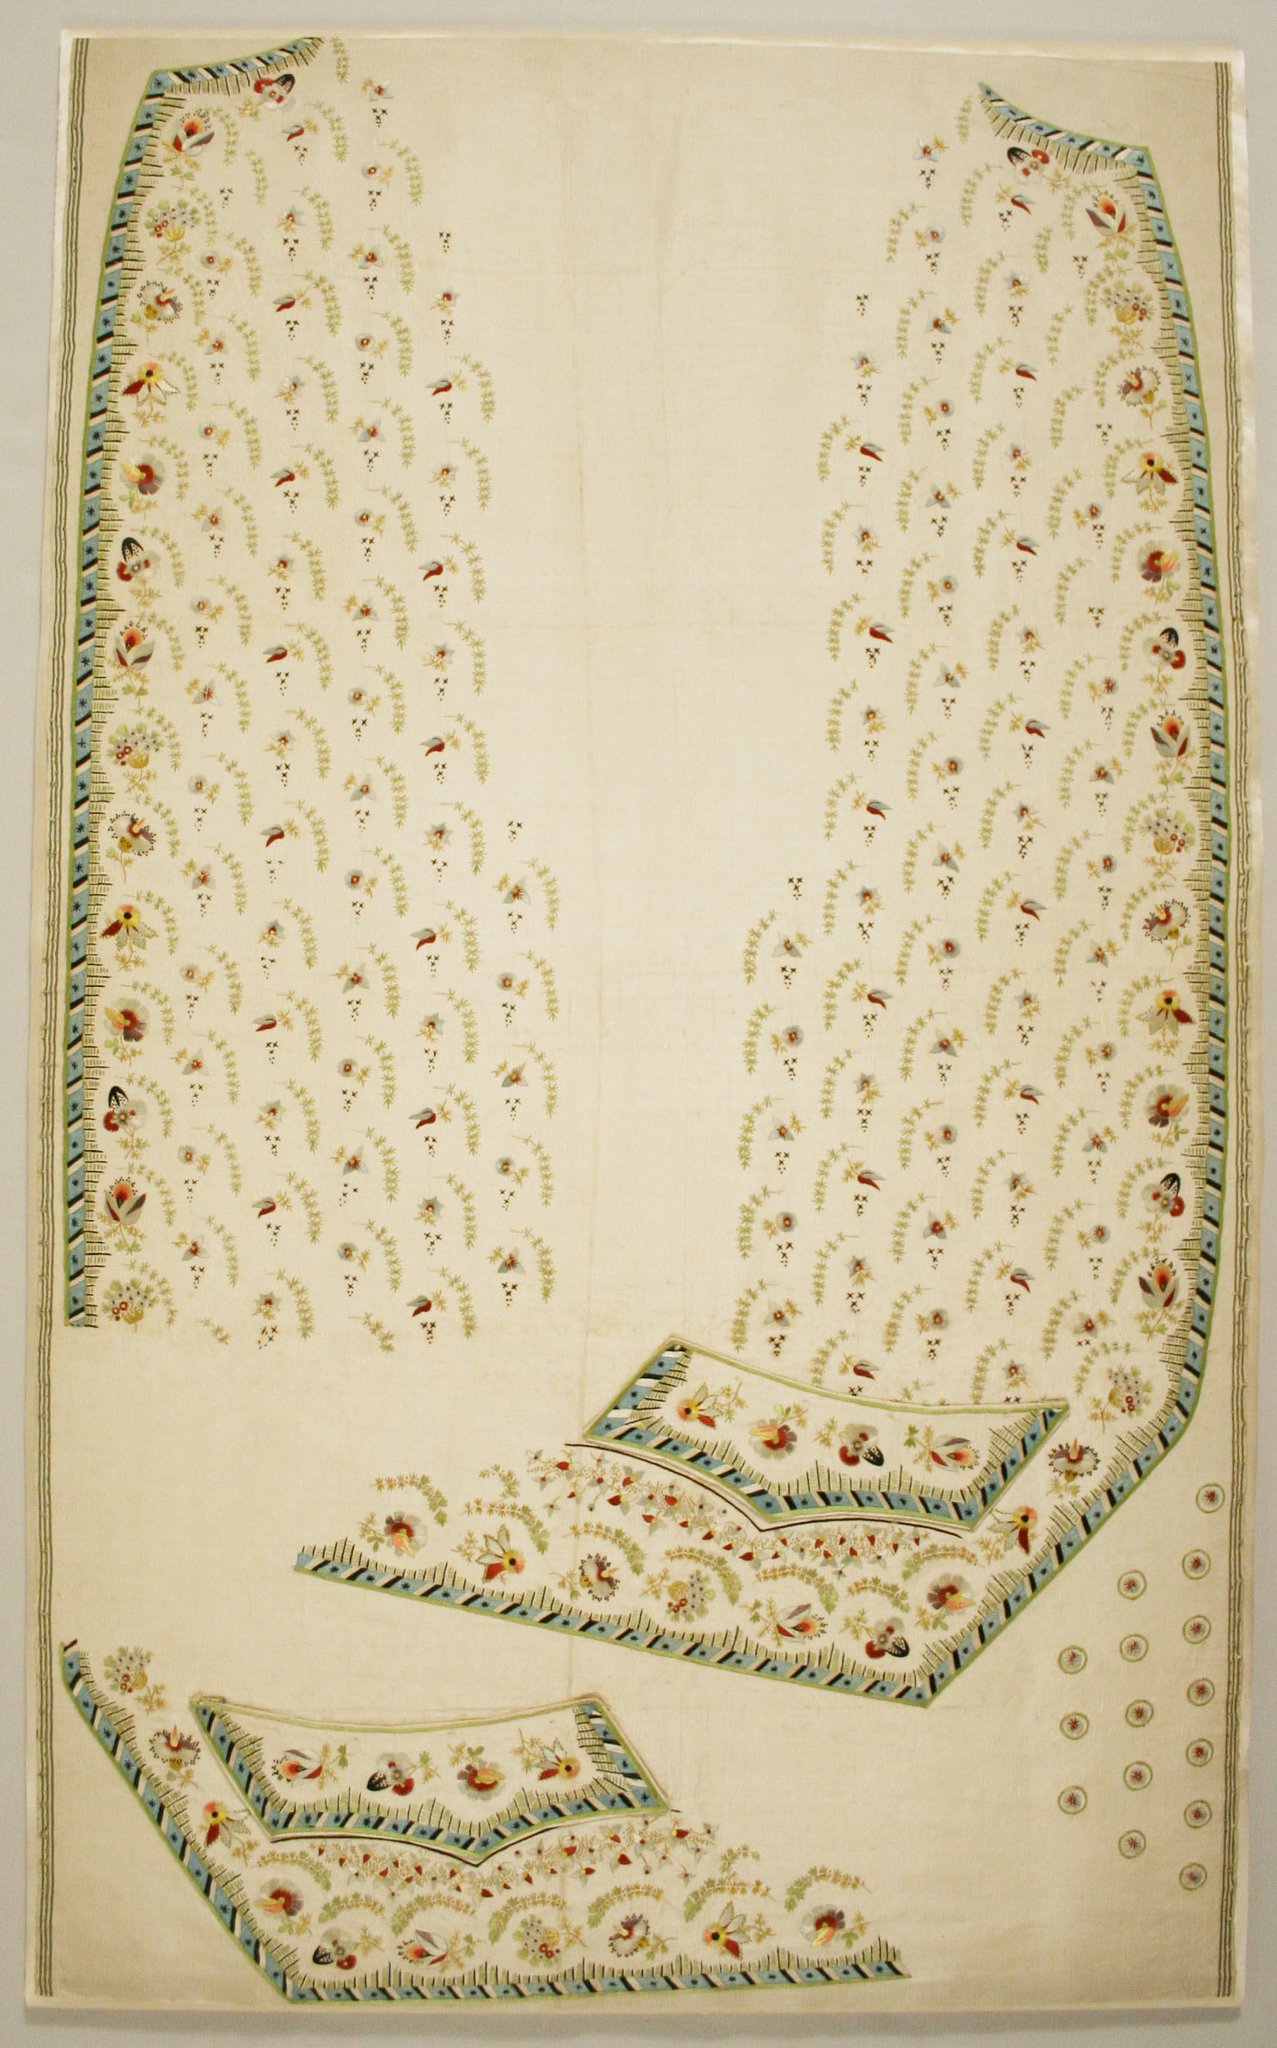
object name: textile panel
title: Waistcoat panel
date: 1780-1785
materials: silk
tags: flowers